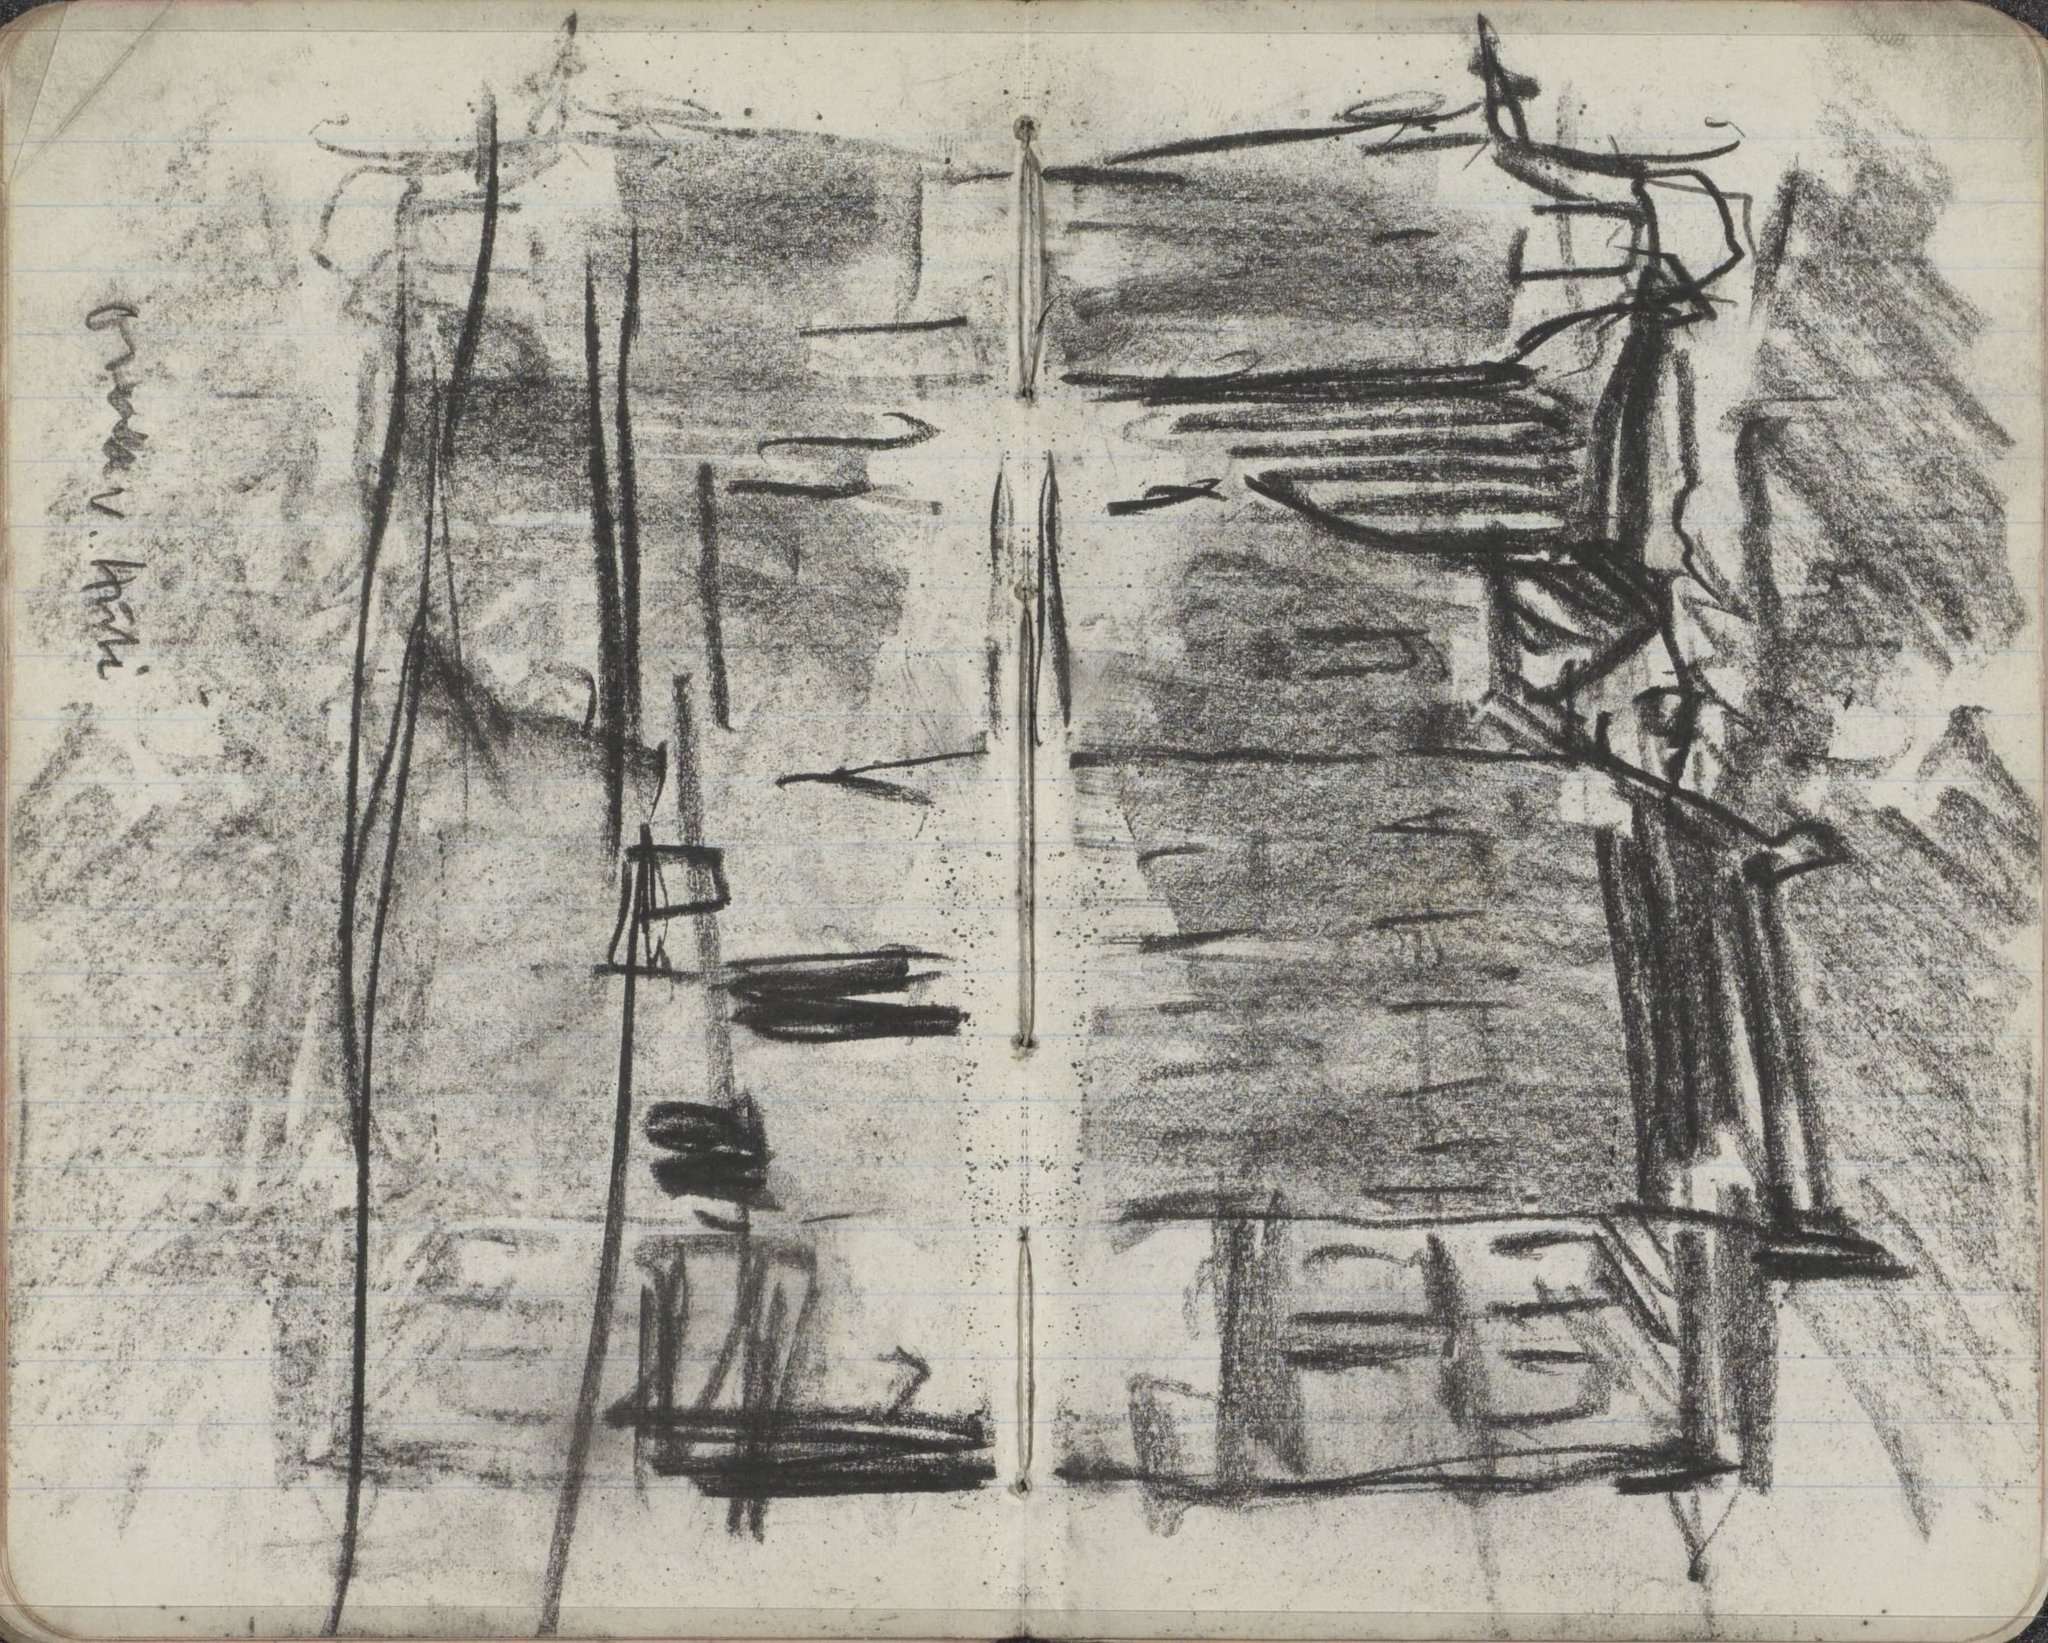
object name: sketchbook leaf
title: Gezicht op het Rokin te Amsterdam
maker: george hendrik breitner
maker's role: draughtsman, painter, print maker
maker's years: 1857-1923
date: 1893-1898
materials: chalk, paper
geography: amsterdam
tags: canals, waters (in city), civic architecture; edifices; dwellings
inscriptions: annotation: ‘[...] v. Arti’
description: Gezien vanuit Rokin 112, kunstenaarsvereniging Arti et Amicitiae. Pagina 63 en pagina 64 uit een schetsboek met 38 bladen.